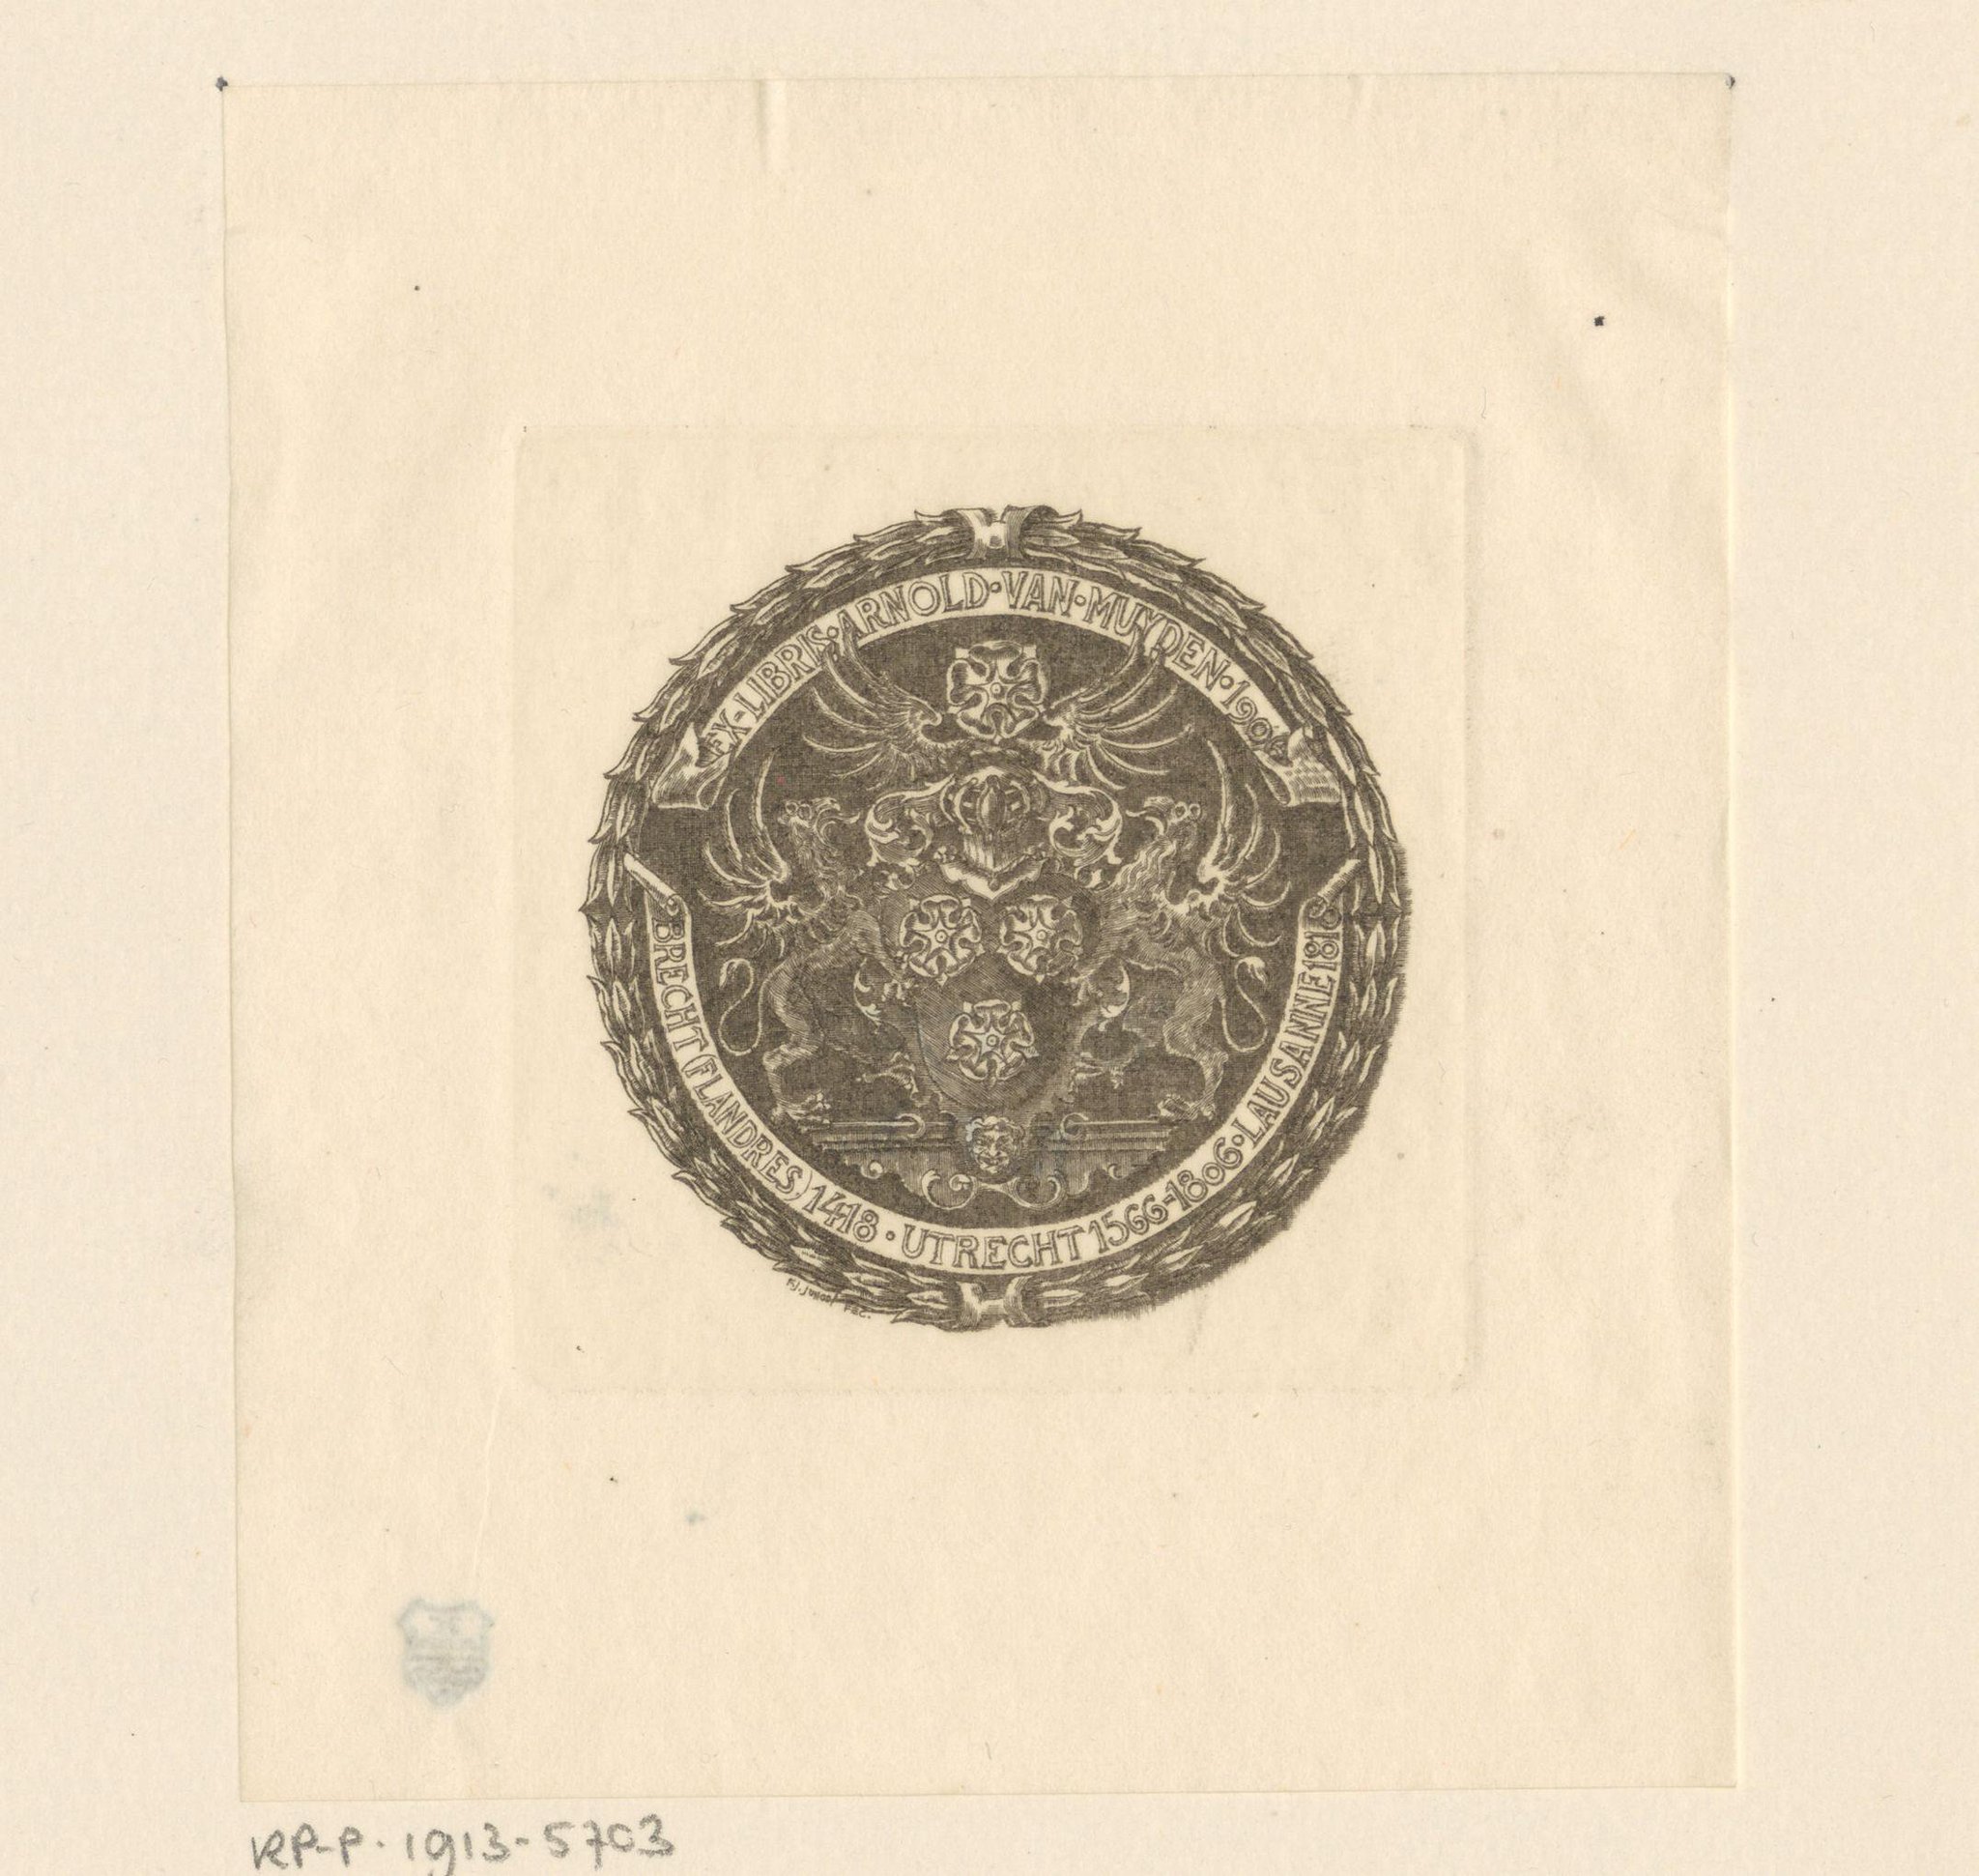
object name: bookplate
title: Ex libris van Arnold van Muyden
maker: fernand-james junod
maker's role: print maker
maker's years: 1872-1953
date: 1906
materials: paper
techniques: etching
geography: switzerland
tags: griffin (lion/eagle); 'griffo' (ripa), armorial bearing, heraldry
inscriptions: collector's mark: Lugt 2233, collector's mark: Lugt 2760